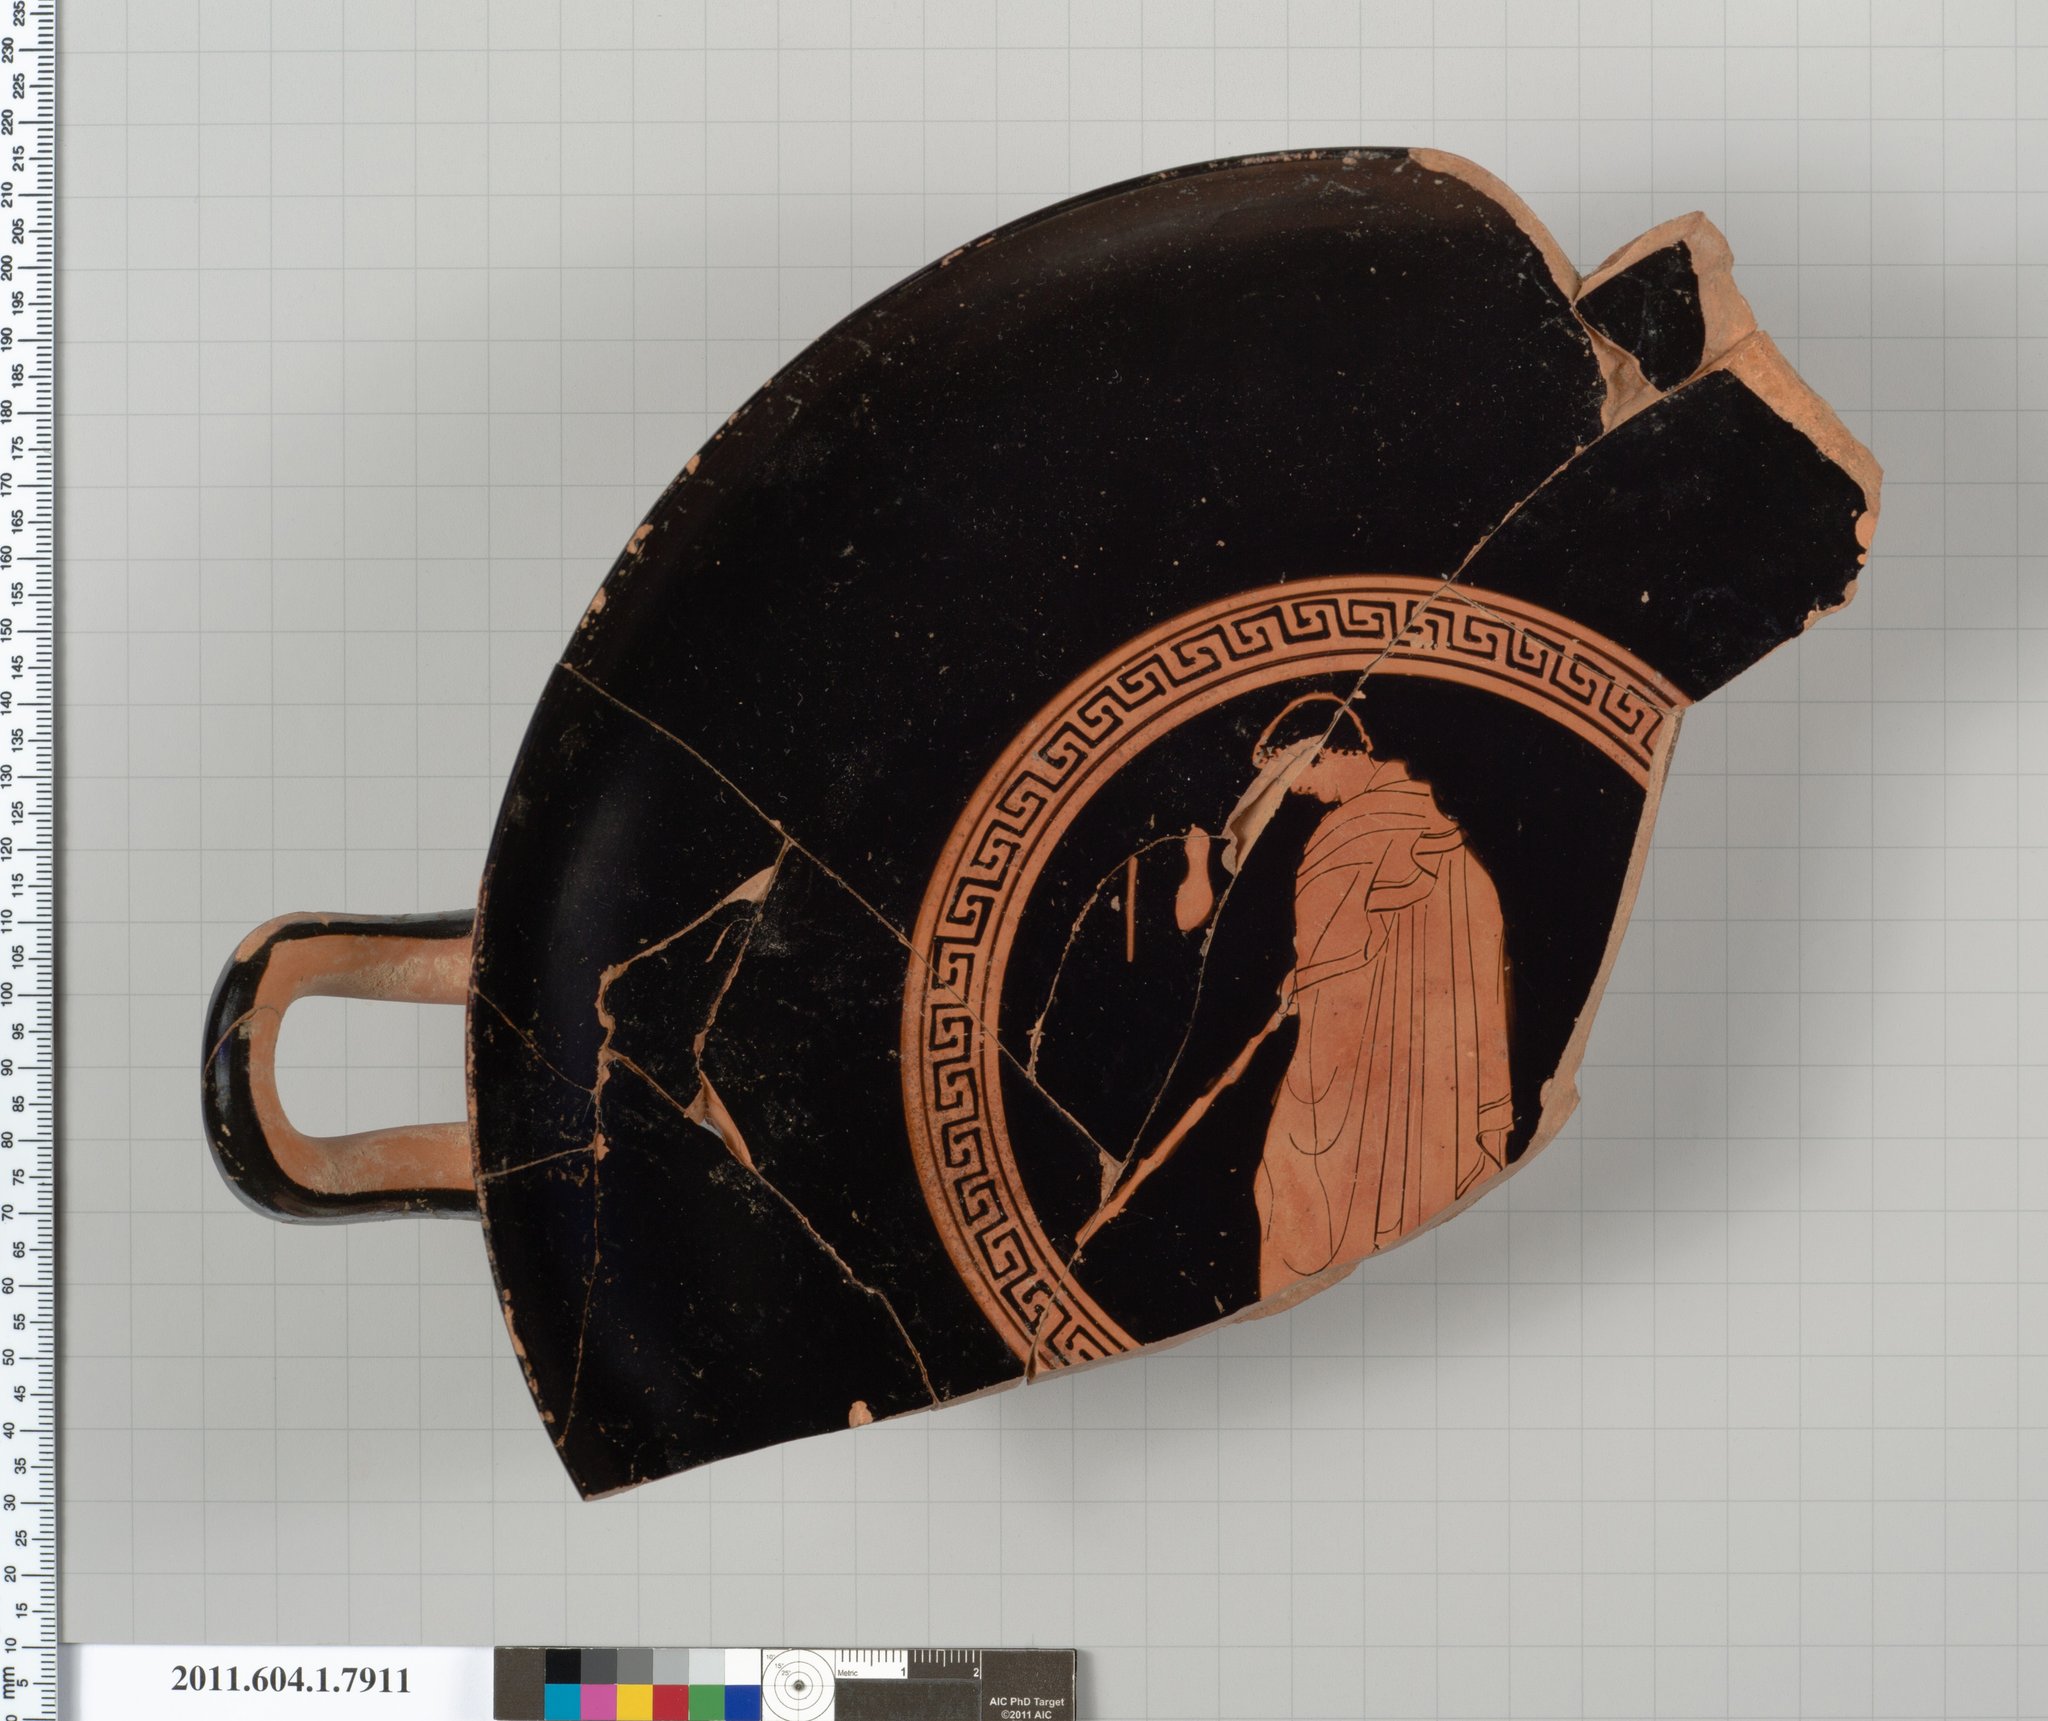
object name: kylix fragment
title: Terracotta fragment of a kylix (drinking cup)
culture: greek, attic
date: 475-451 BCE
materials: terracotta